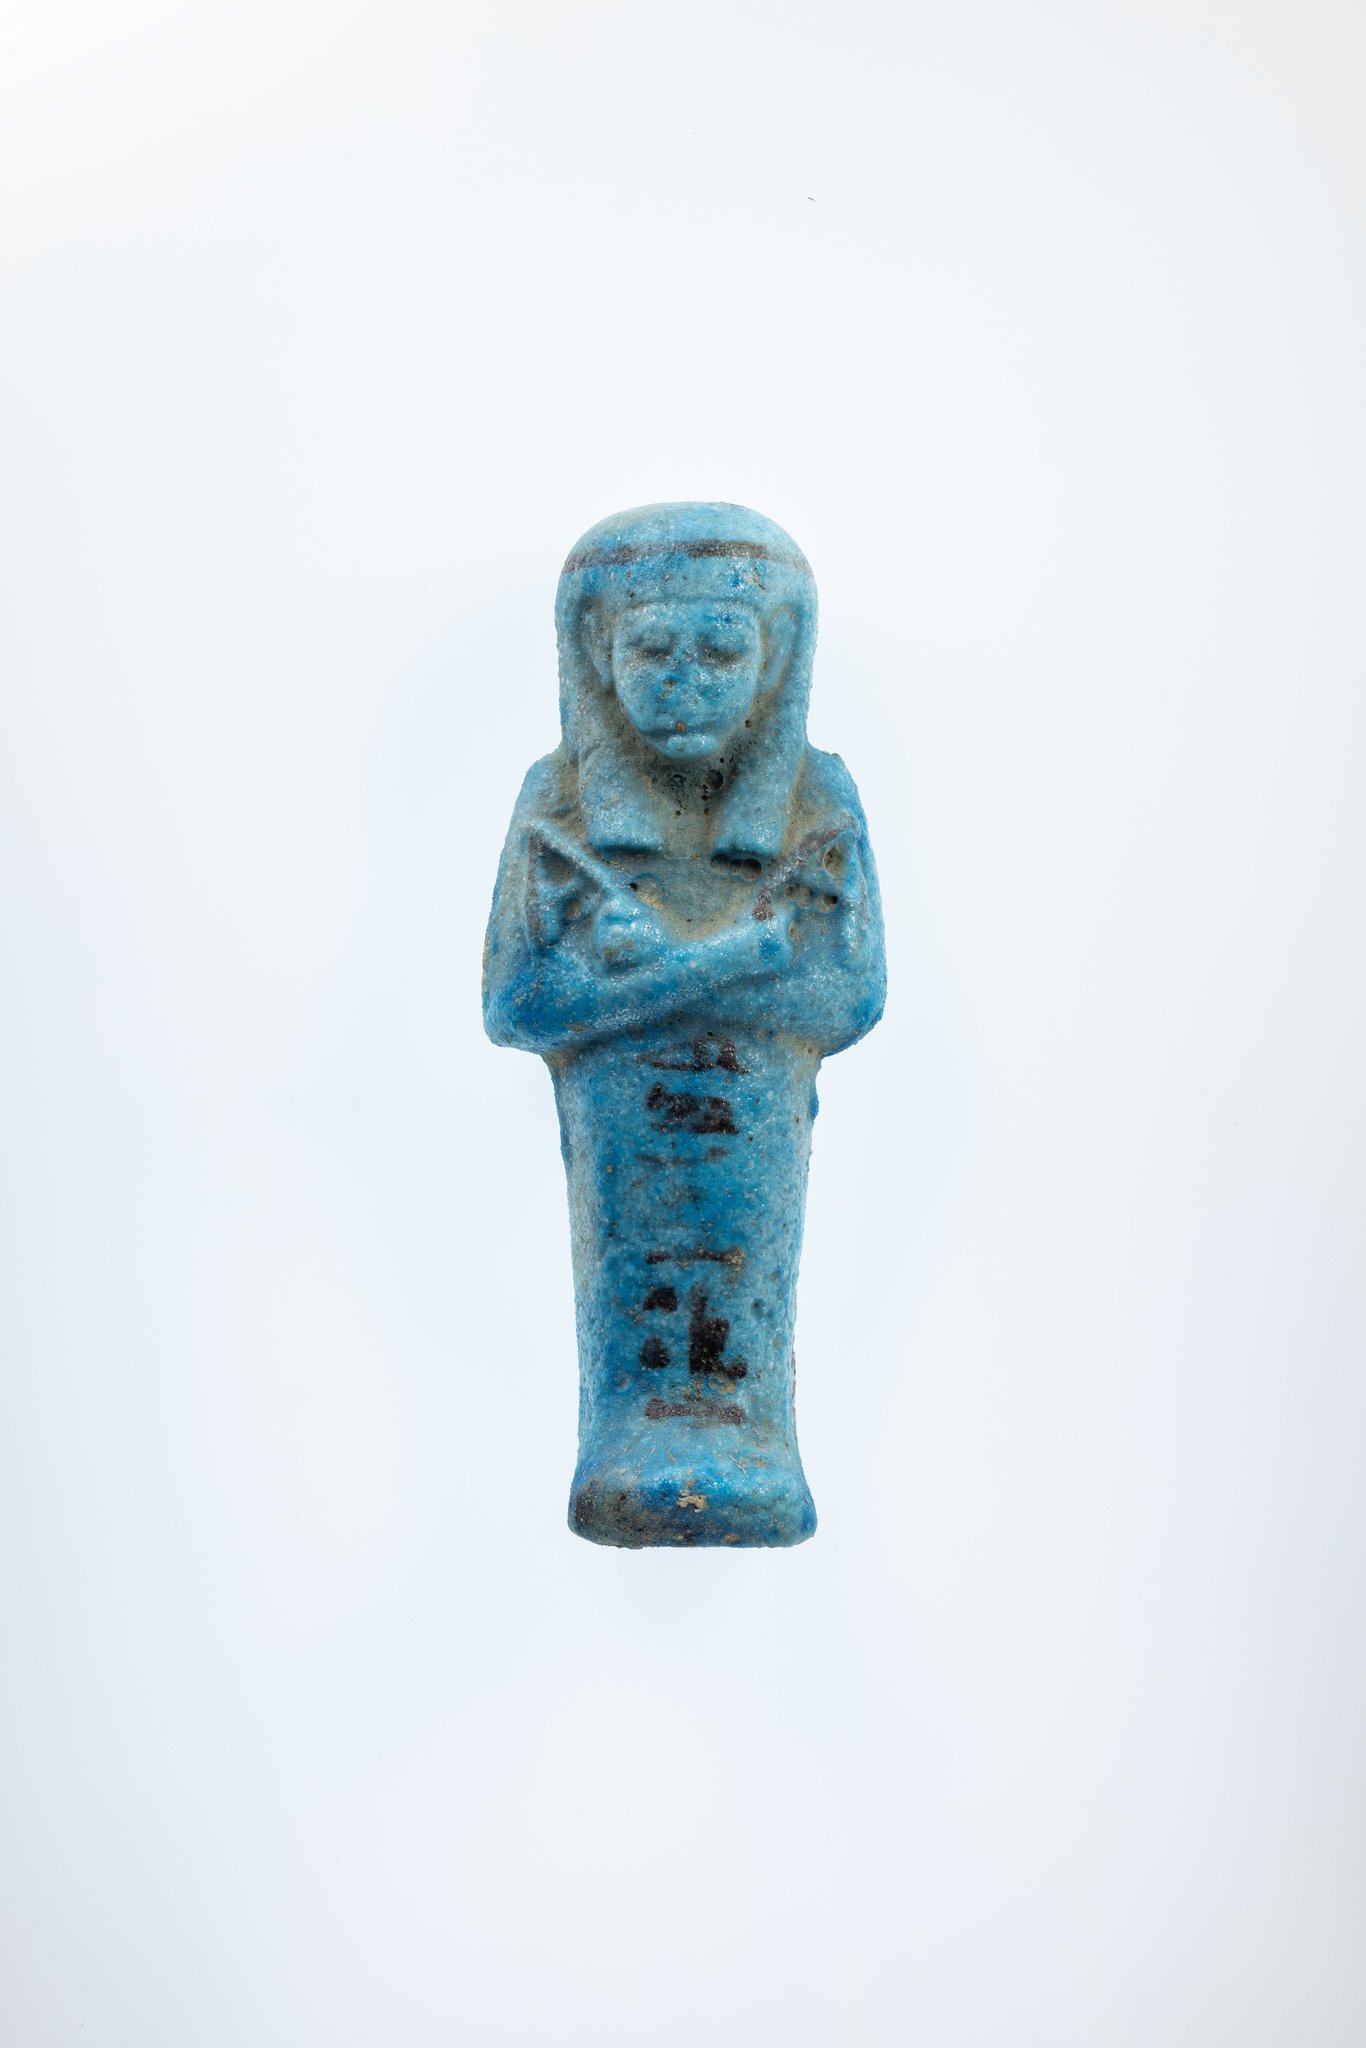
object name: shabti, nesenaset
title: Shabti of Nesenaset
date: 1070-945 BCE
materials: faience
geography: egypt